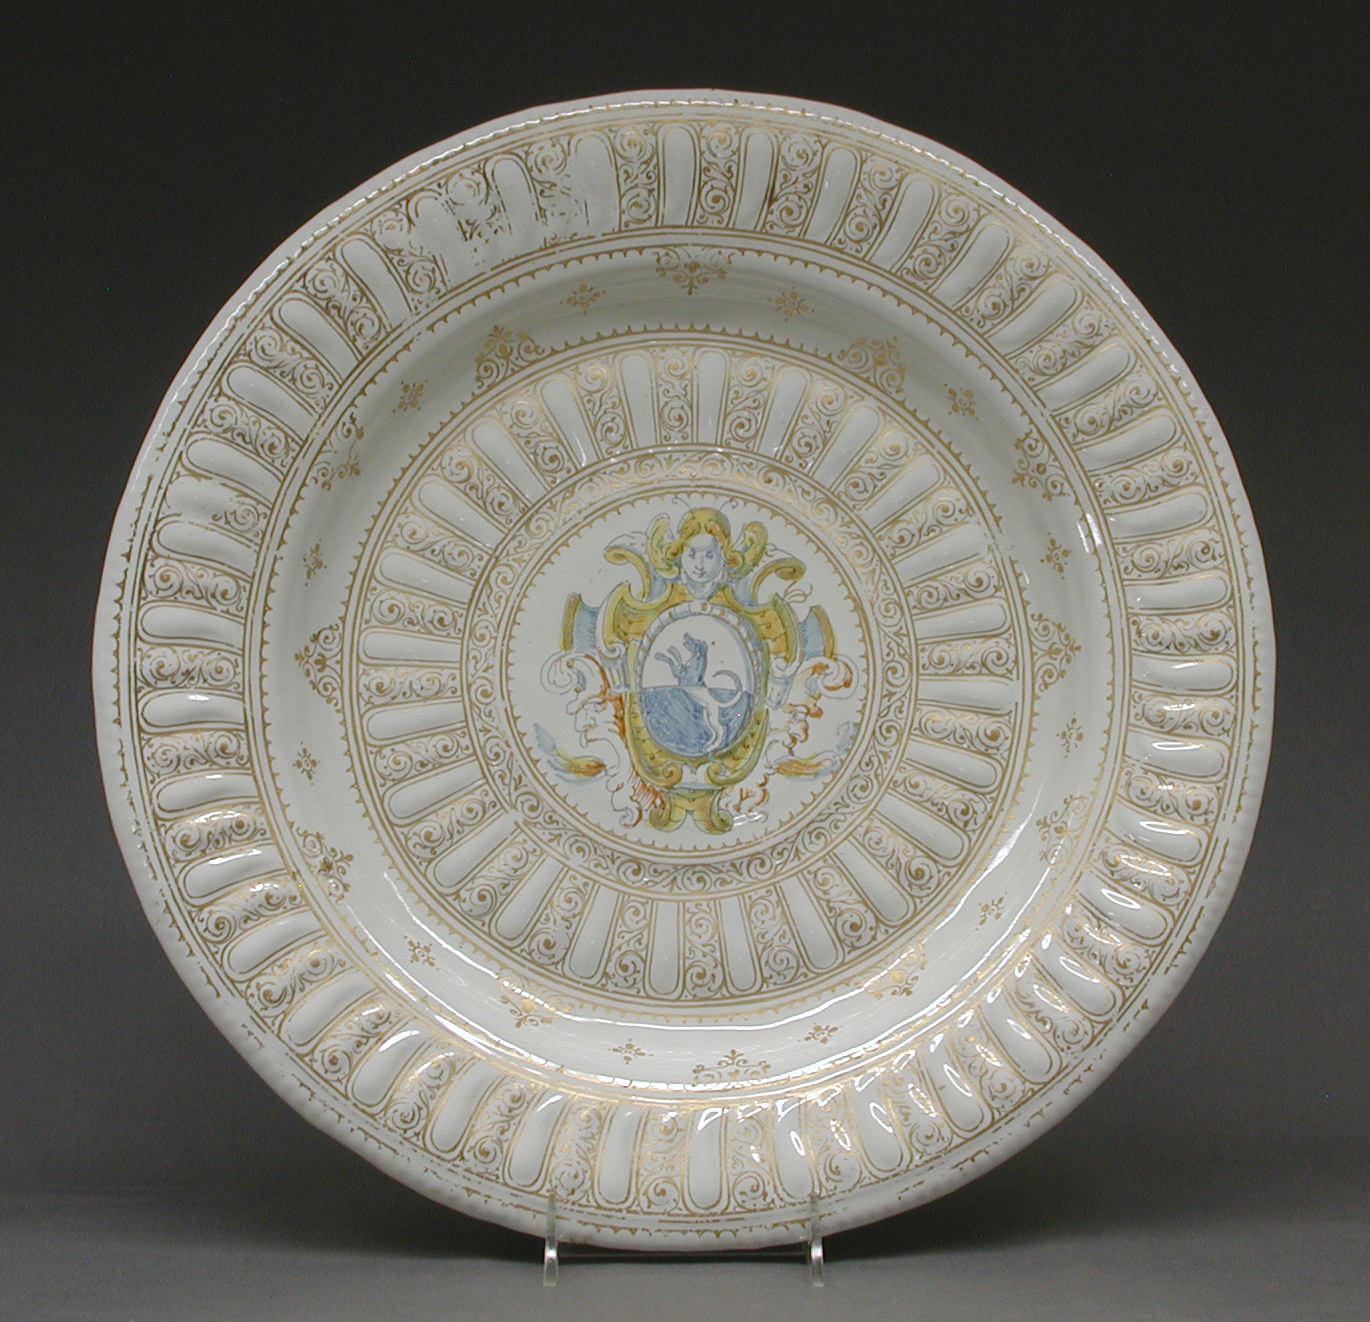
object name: dish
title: Dish (part of a set)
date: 1801-1900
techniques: maiolica, glazing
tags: animals,insignia